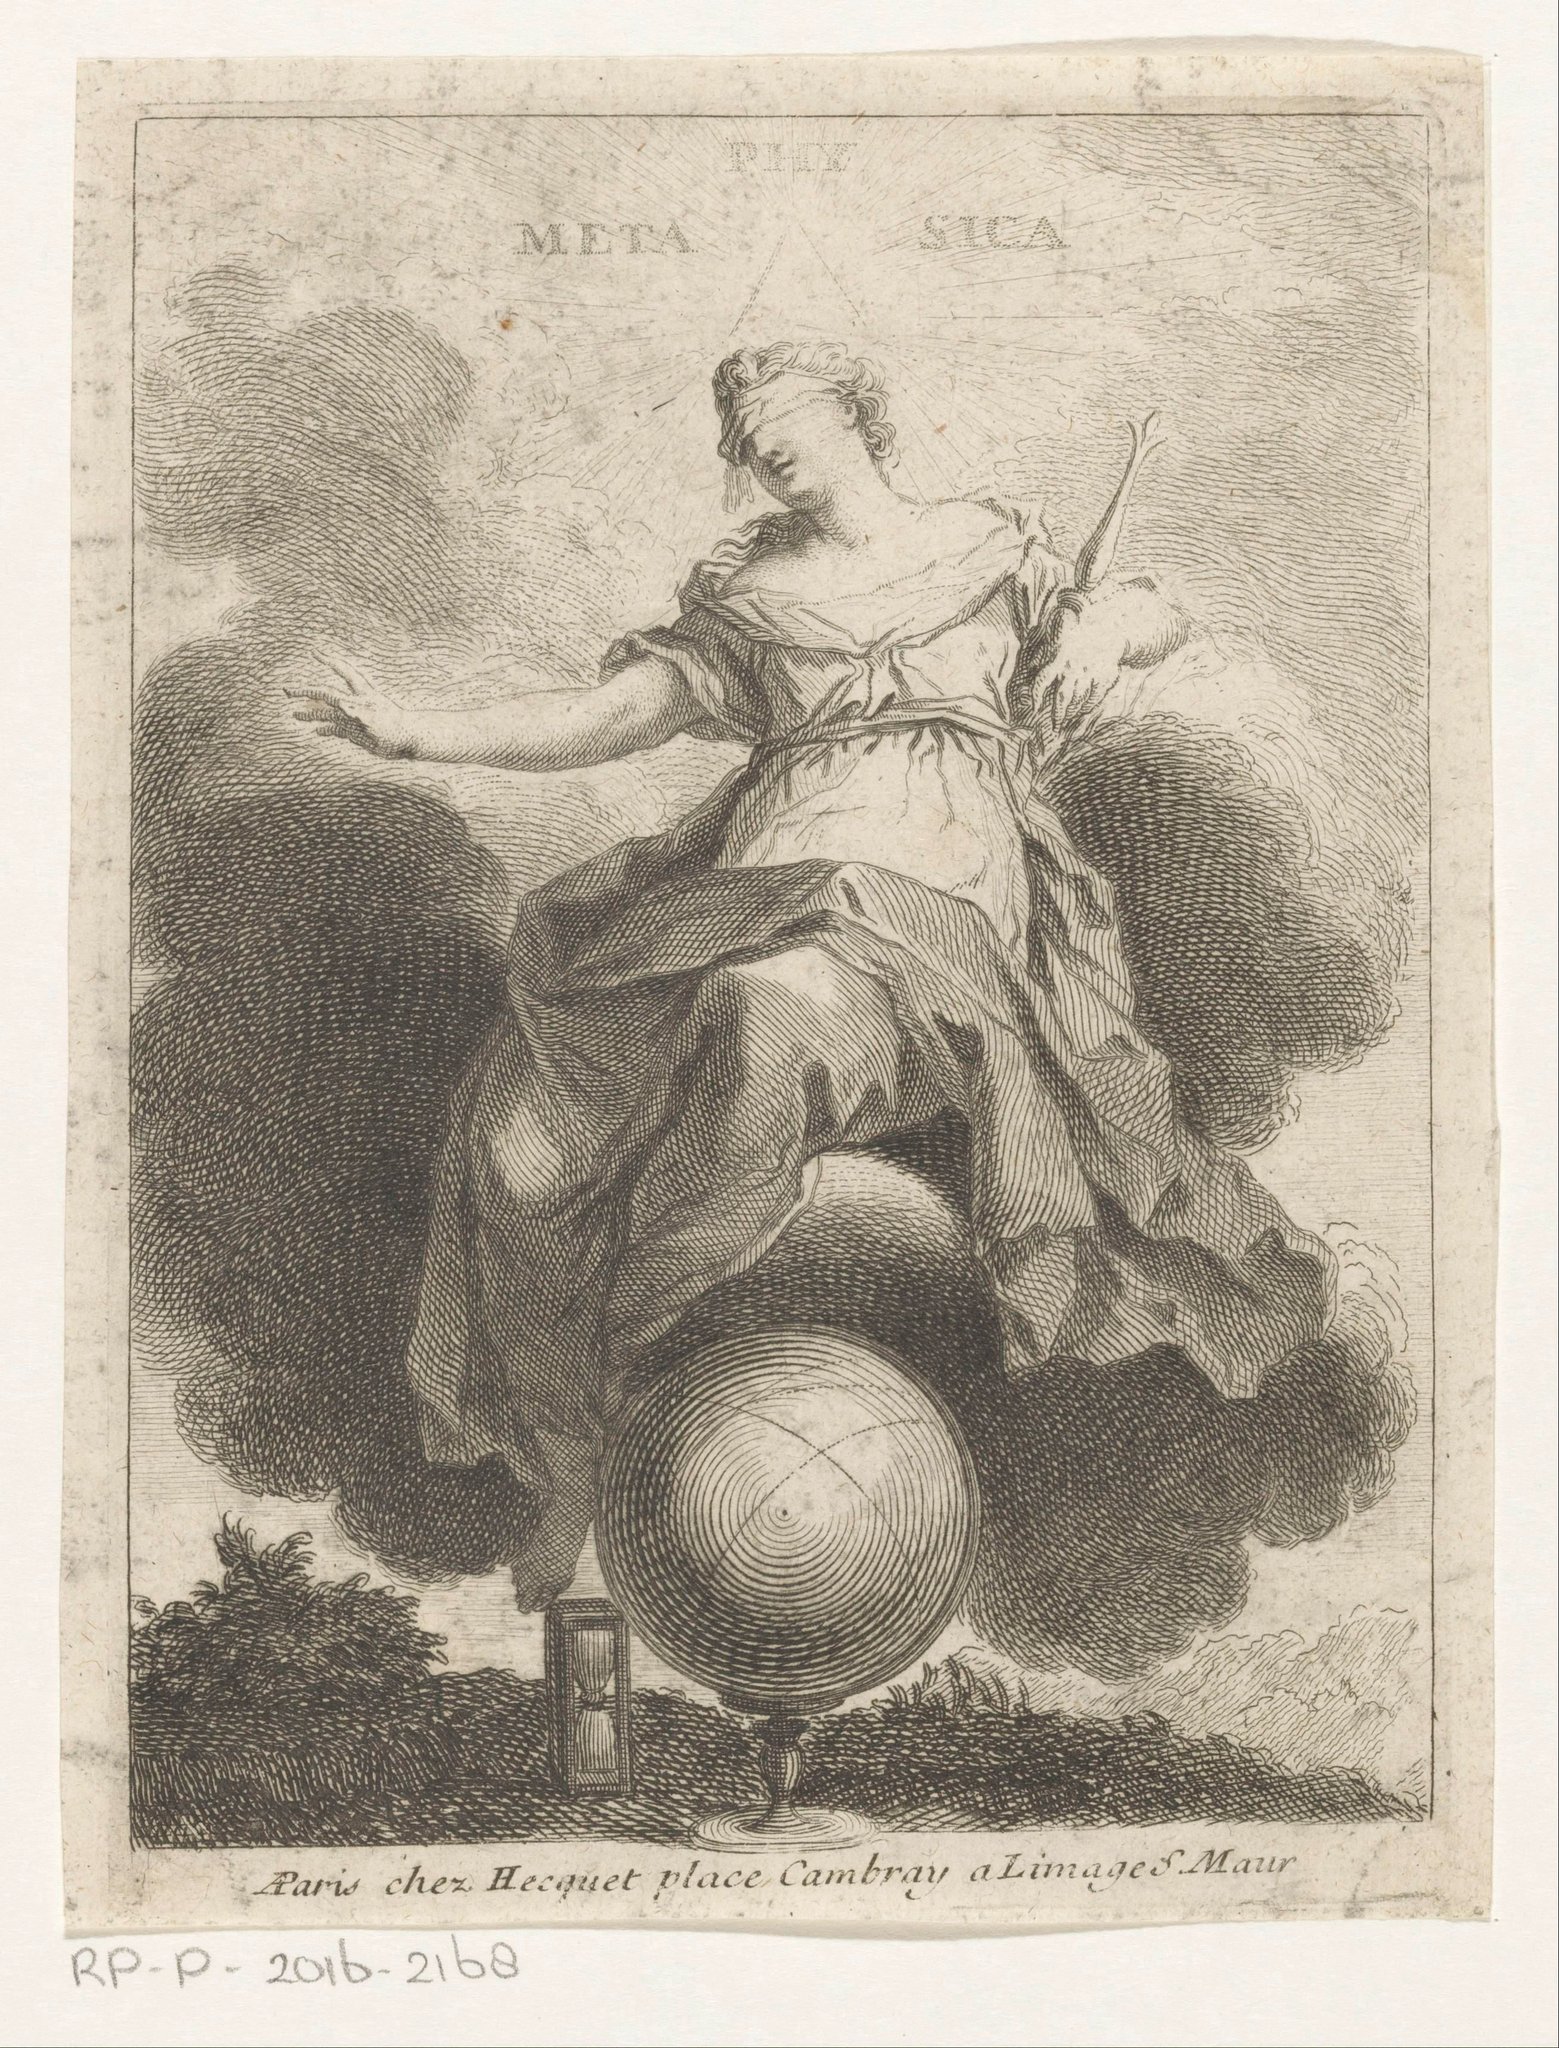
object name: print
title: Metafysica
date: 1703-1775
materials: paper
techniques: engraving, etching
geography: paris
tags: metaphysics, 'metaphysica'; 'metafisica' (ripa)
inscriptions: collector's mark: Lugt 2228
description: Prent afkomstig uit een plakalbum met titelprenten, ornamenten etc. op blauw papier in 1983 uit elkaar gehaald. Volgens een notitie op verso zat de prent op p. 211 van dit album.